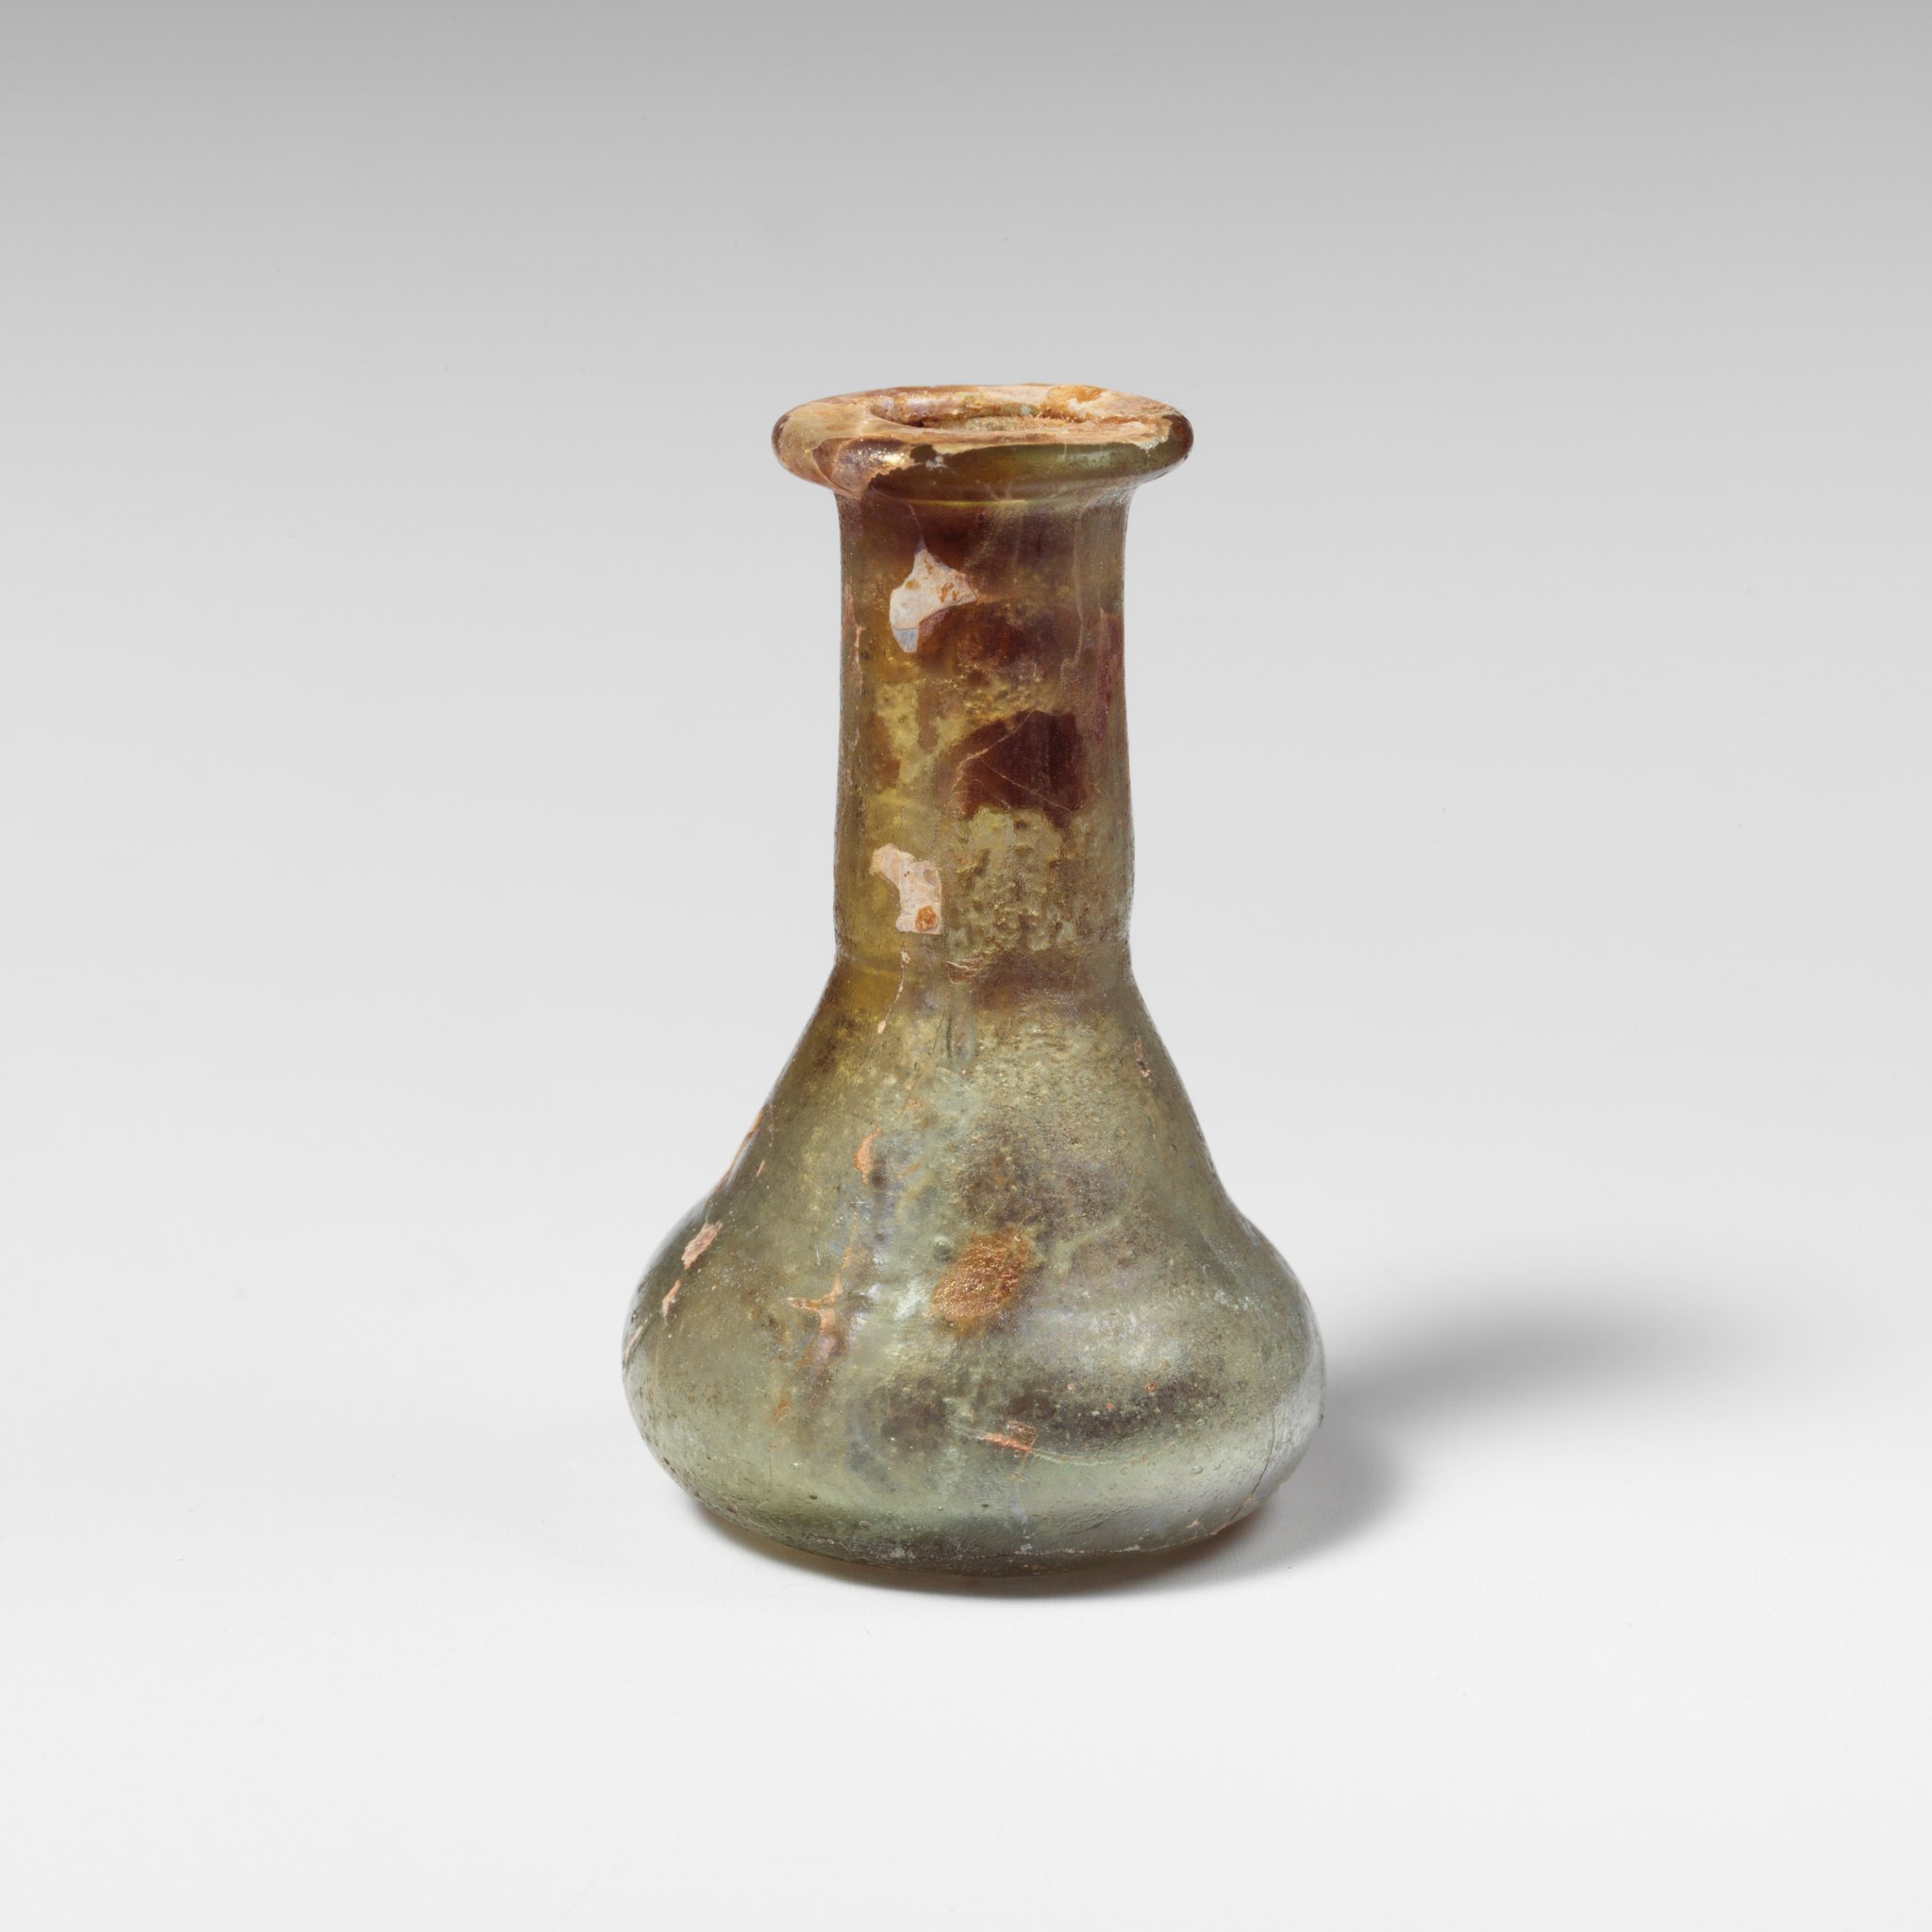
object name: perfume bottle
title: Glass perfume bottle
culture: roman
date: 1-100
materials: glass